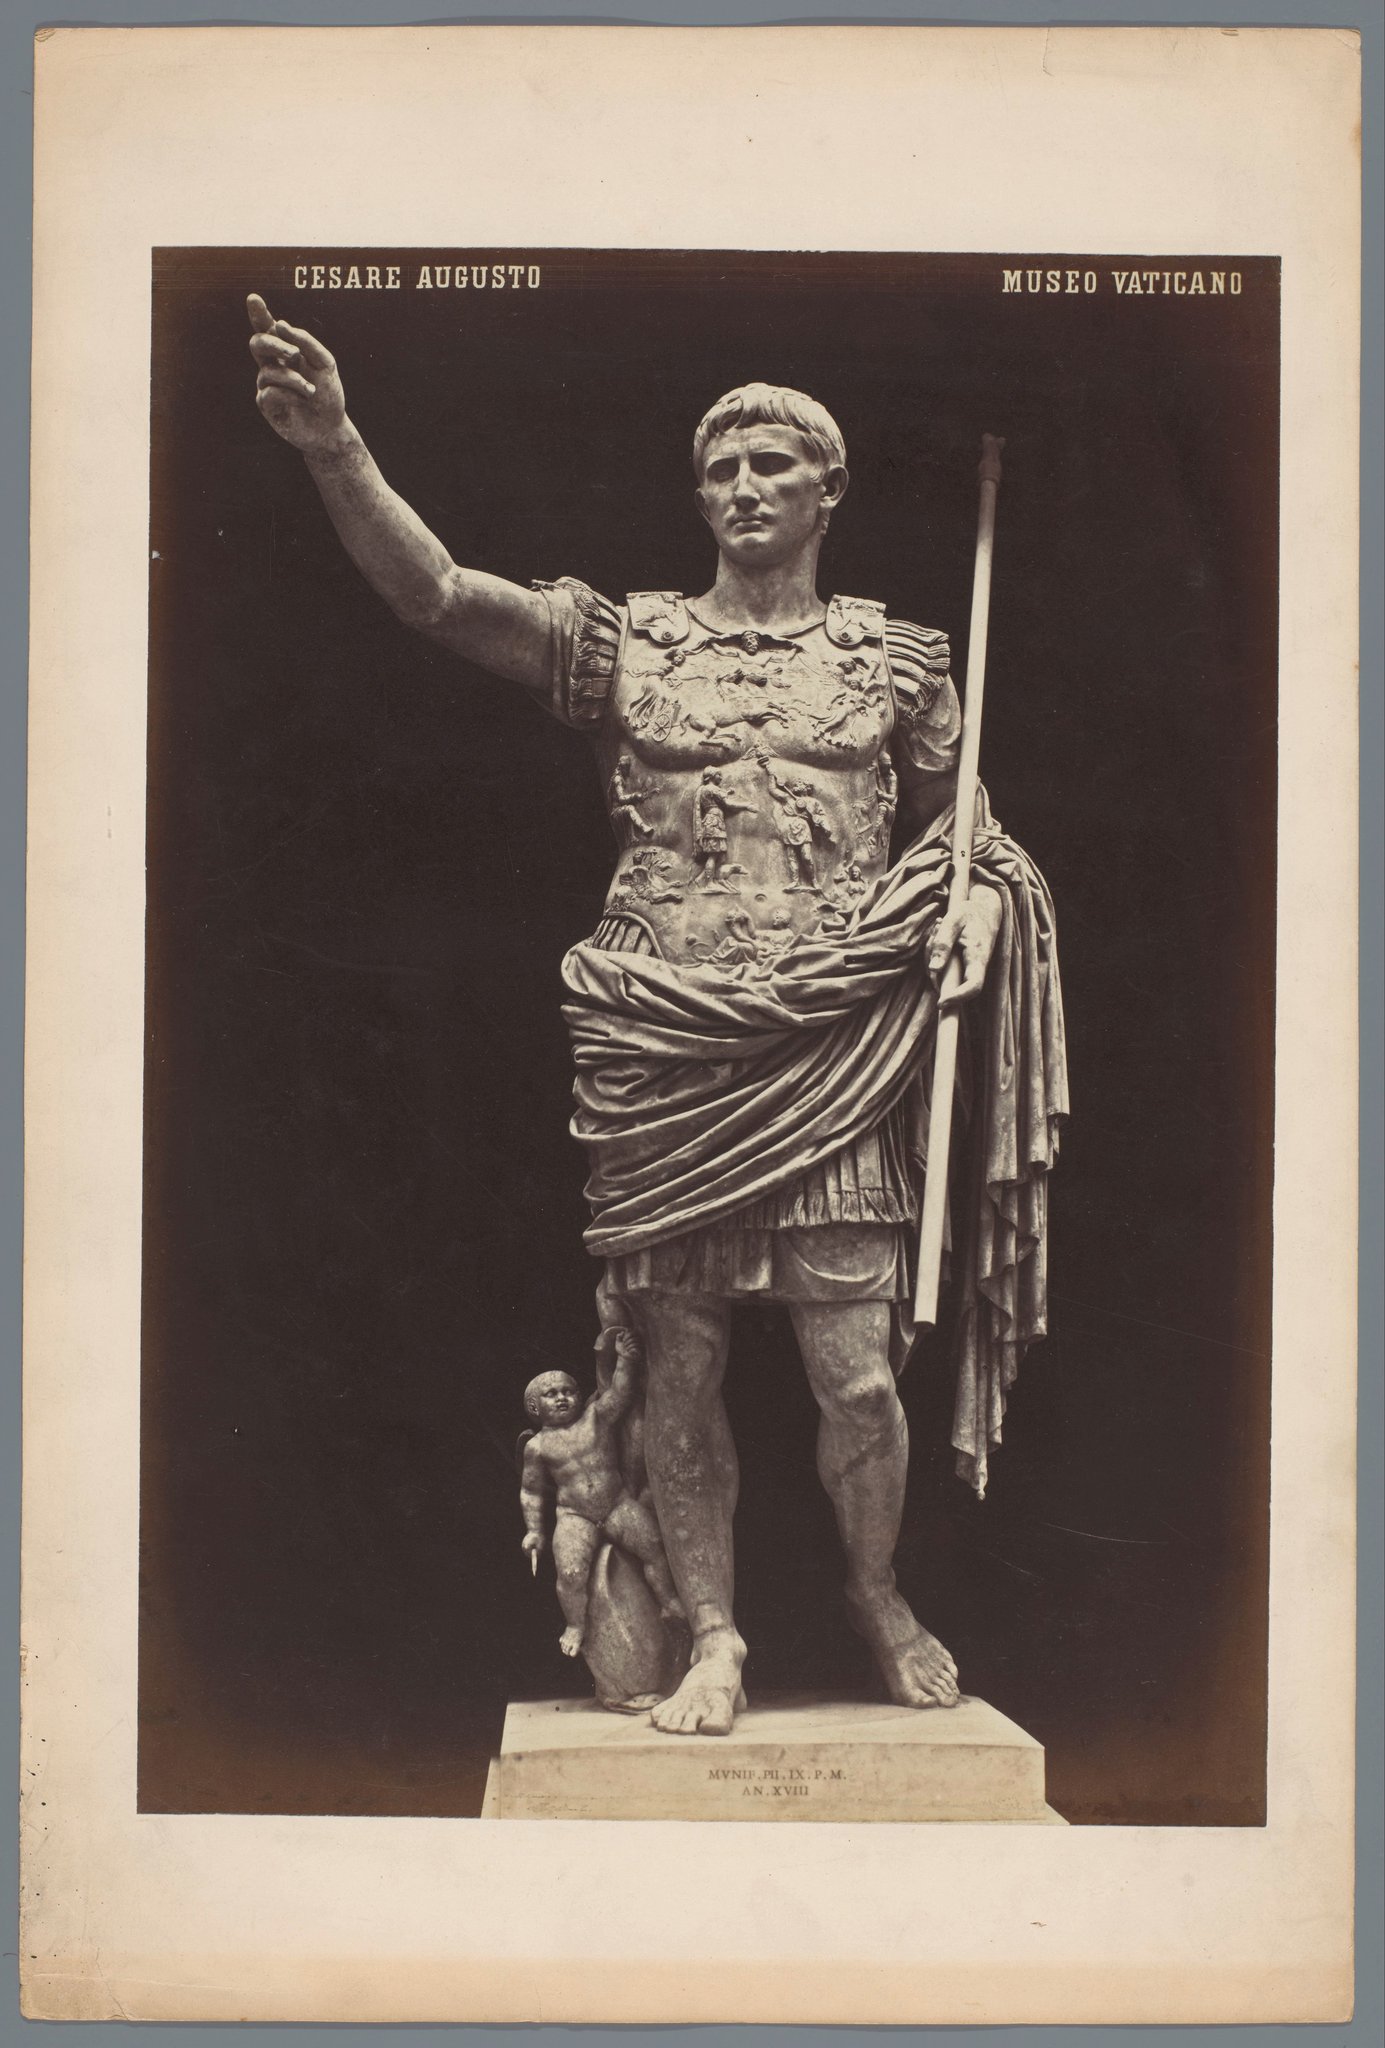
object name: photograph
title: Augustus van Prima Porta in de Vaticaanse Musea te Vaticaanstad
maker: Anonymous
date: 1875-1900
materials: cardboard, photographic support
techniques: albumen print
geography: vatican museums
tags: harness, sculpture, cupids: 'amores', 'amoretti', 'putti', (story of) augustus, the roman emperor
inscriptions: collector's mark: Lugt 3937